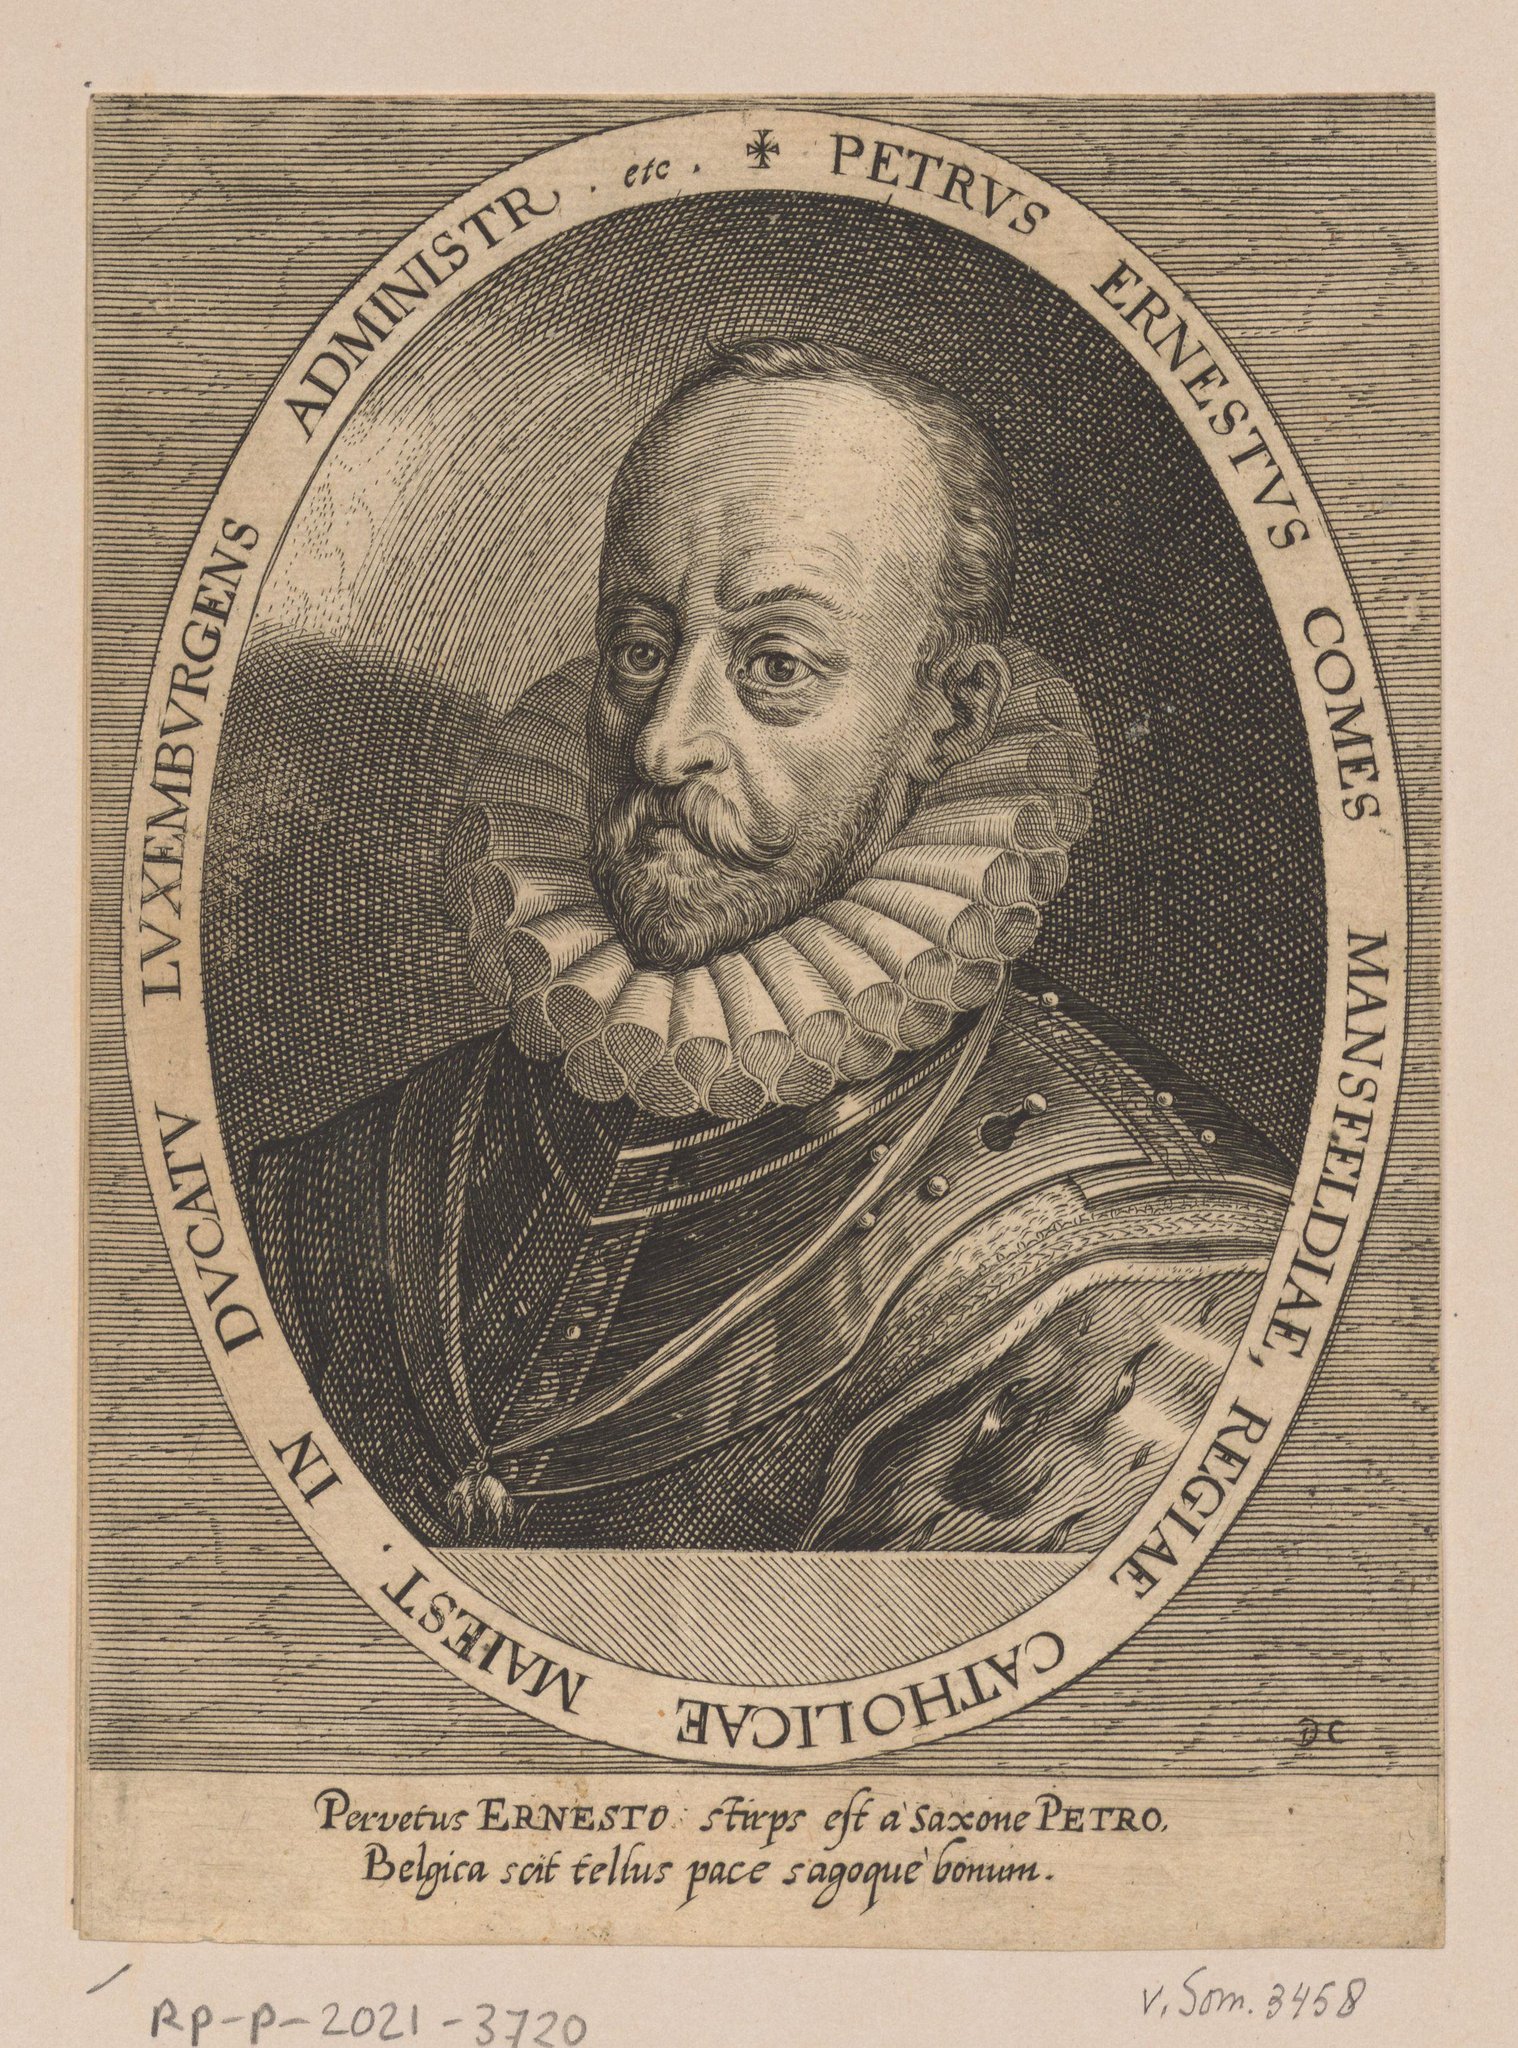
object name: print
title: Portretten van bekende personen uit de zestiende eeuw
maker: dominicus custos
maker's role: print maker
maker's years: 1560-1615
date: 1600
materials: paper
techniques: engraving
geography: germany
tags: ornament ~ medallion, armour, historical persons, knighthood order of the golden fleece - insignia of a knighthood order, e.g.: badge, chain (with name of order)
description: Prent komt uit het tweede deel van Atrium Heroicum.